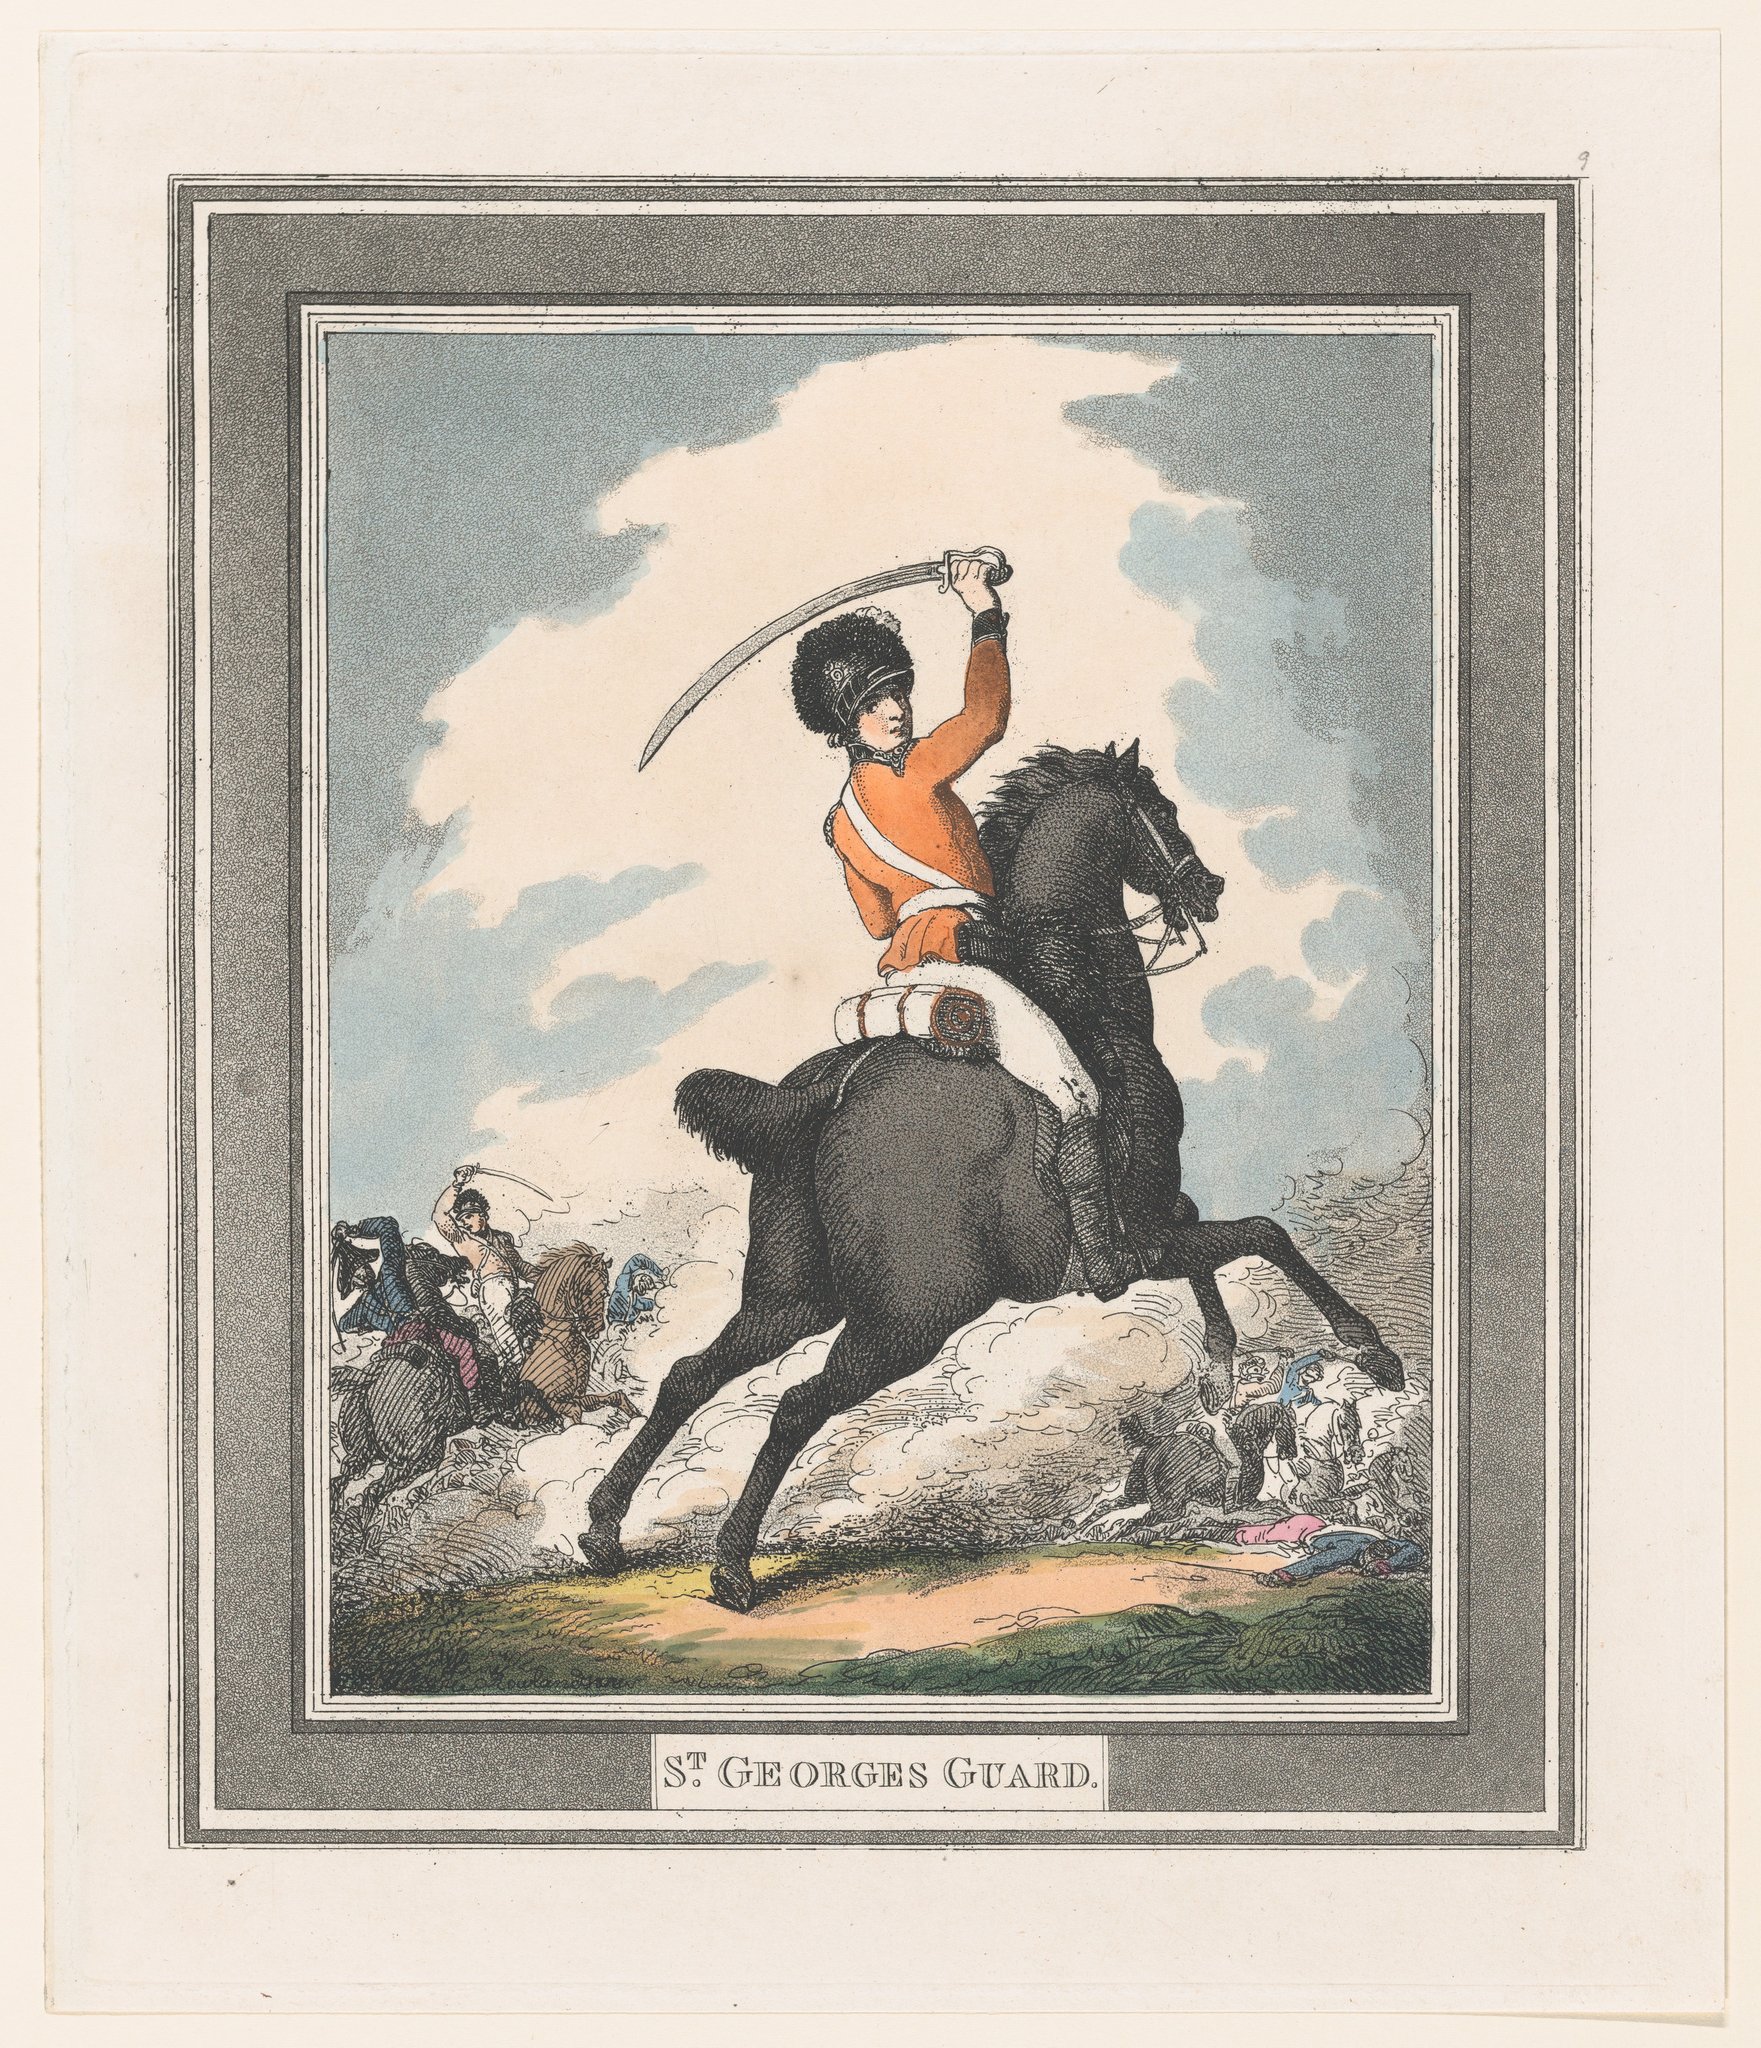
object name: print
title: St George's Guard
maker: thomas rowlandson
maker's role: artist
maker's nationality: british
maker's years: 1757-1827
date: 1798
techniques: aquatint, etching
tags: swords,men,horses